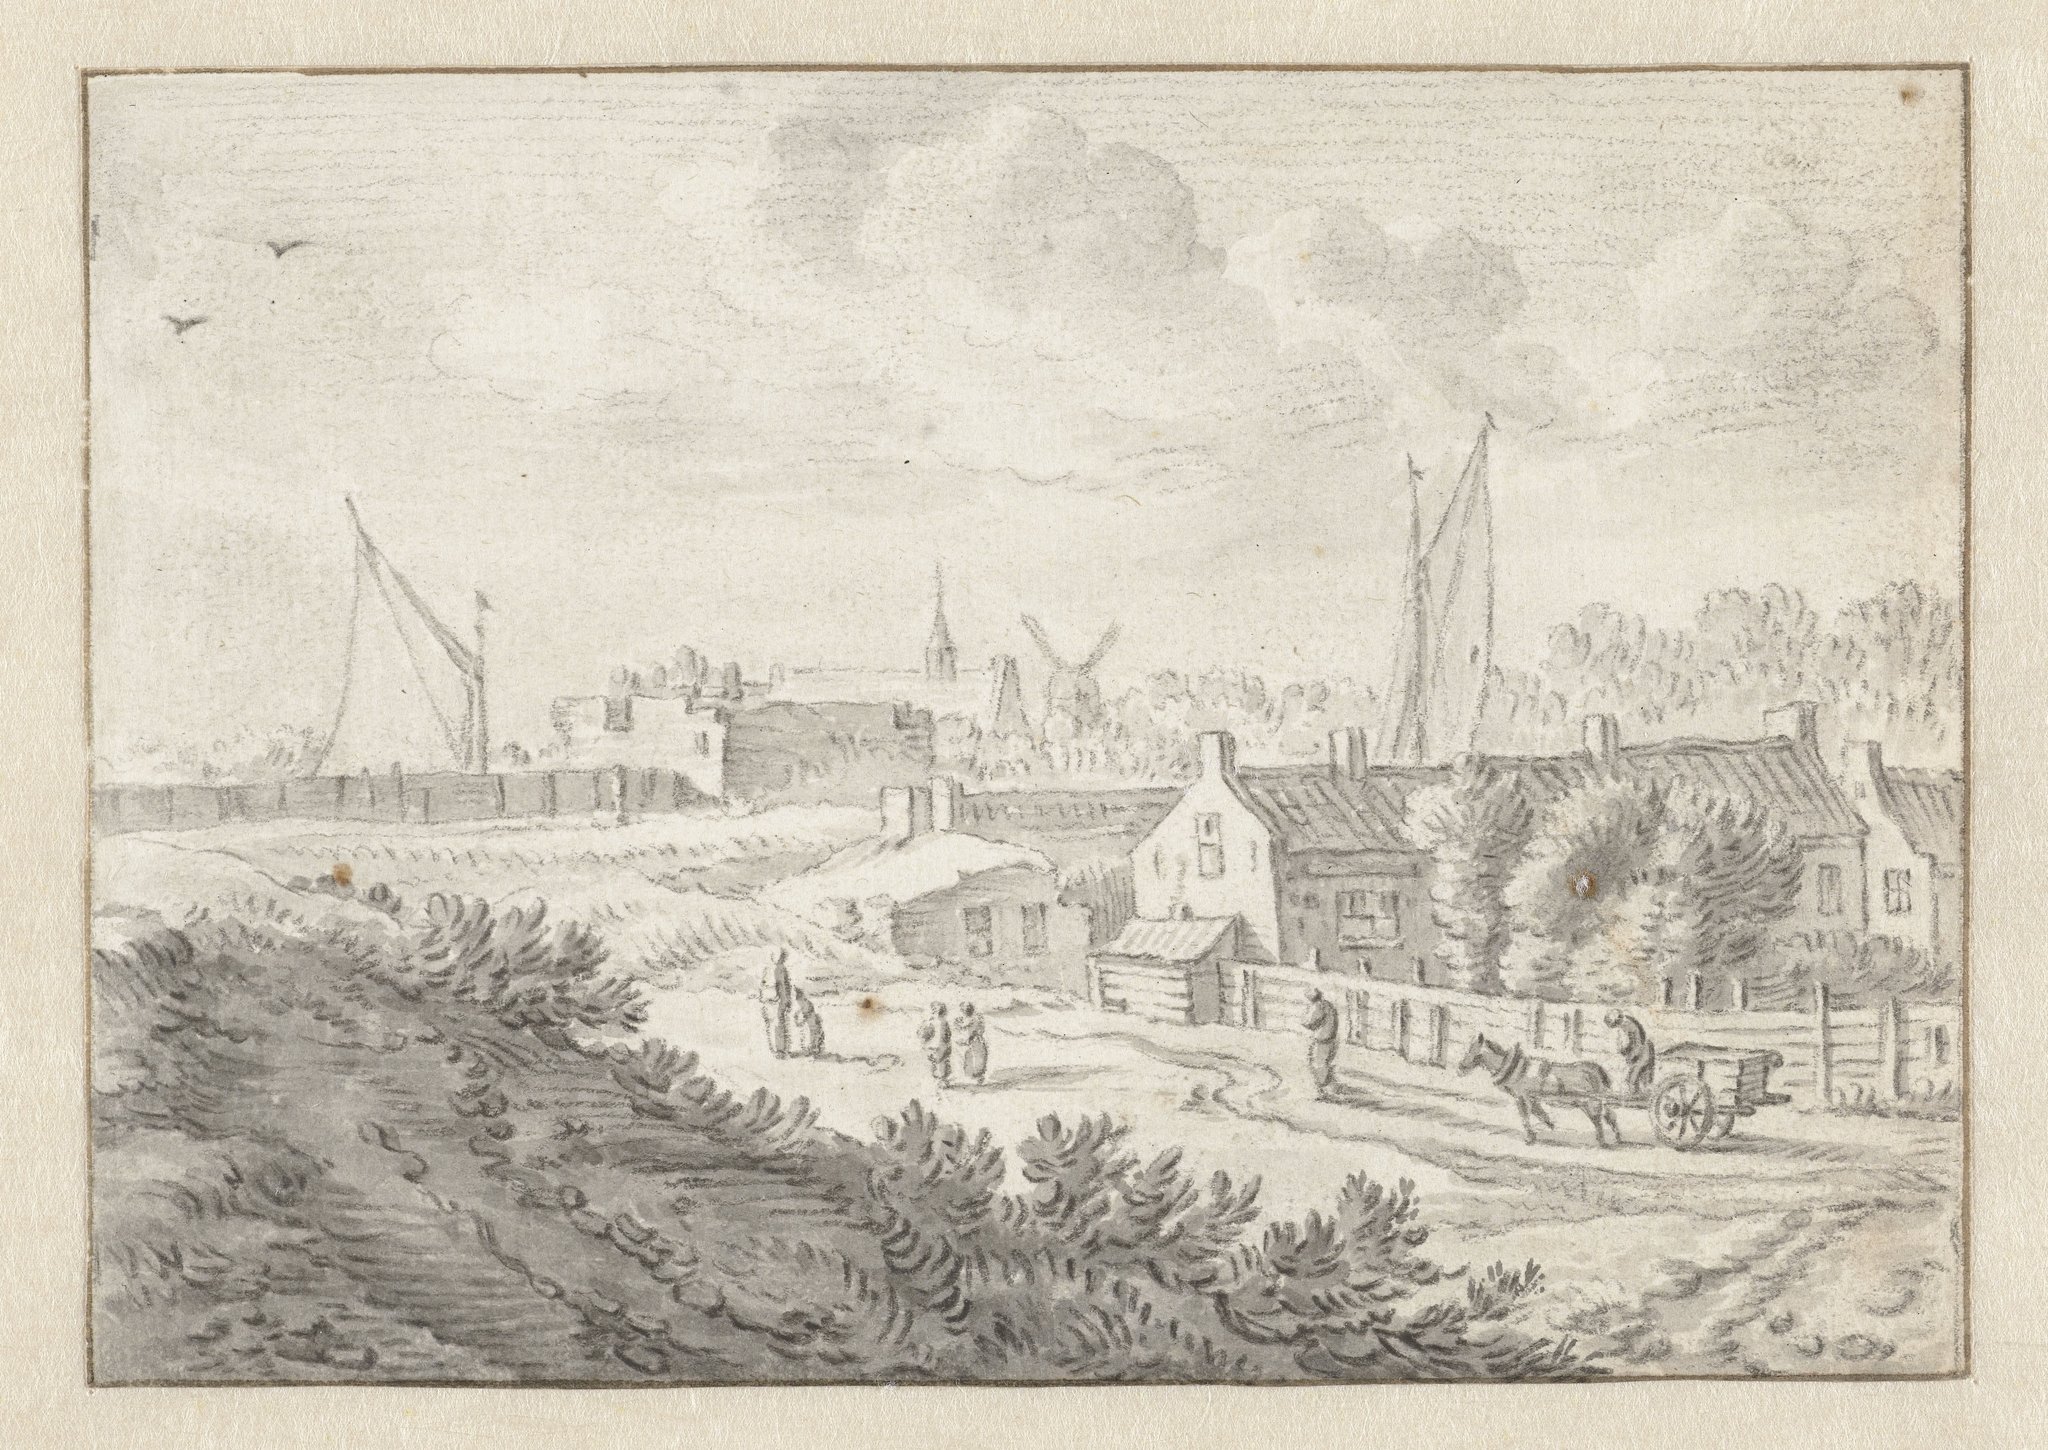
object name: drawing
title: Gezicht op de stadswal van Utrecht bij de Probeertoren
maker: herman saftleven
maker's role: draughtsman, painter, print maker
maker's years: 1609-1685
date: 1619-1685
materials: chalk, paper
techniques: brush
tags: towers ~ fortified city, city-walls, utrecht